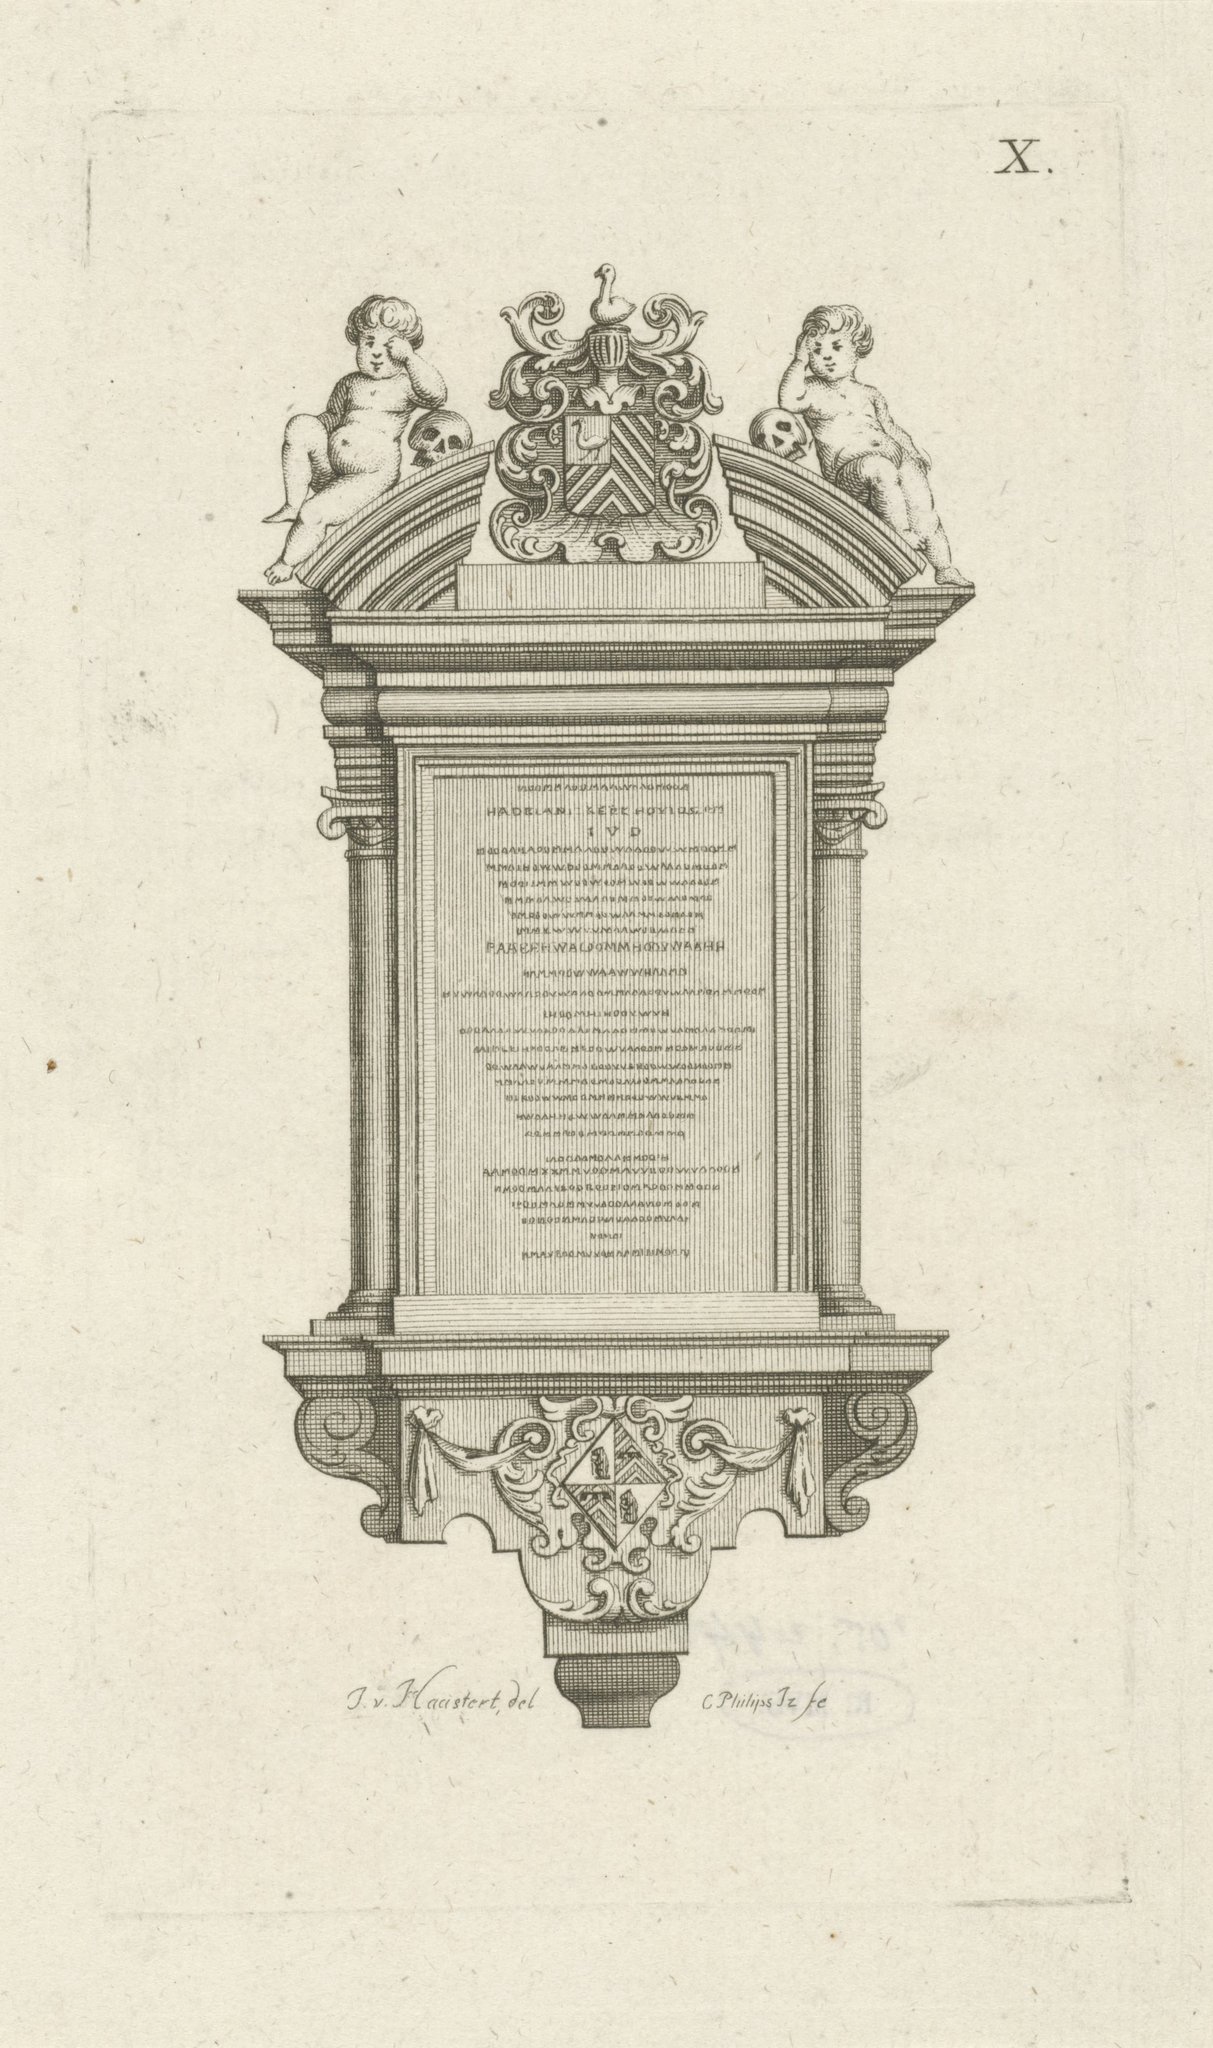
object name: print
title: Epitaaf van Adriaan Teding van Berkhout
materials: paper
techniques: etching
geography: amsterdam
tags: hoorn (north holland), the hague, piece of sculpture, reproduction of a piece of sculpture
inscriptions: collector's mark: Lugt 2228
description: Prent gebruikt in: P. Timareten, Verzameling van gedenkstukken in Nederland, ’s-Gravenhage 1777, dl 1, afb. na p. 74.